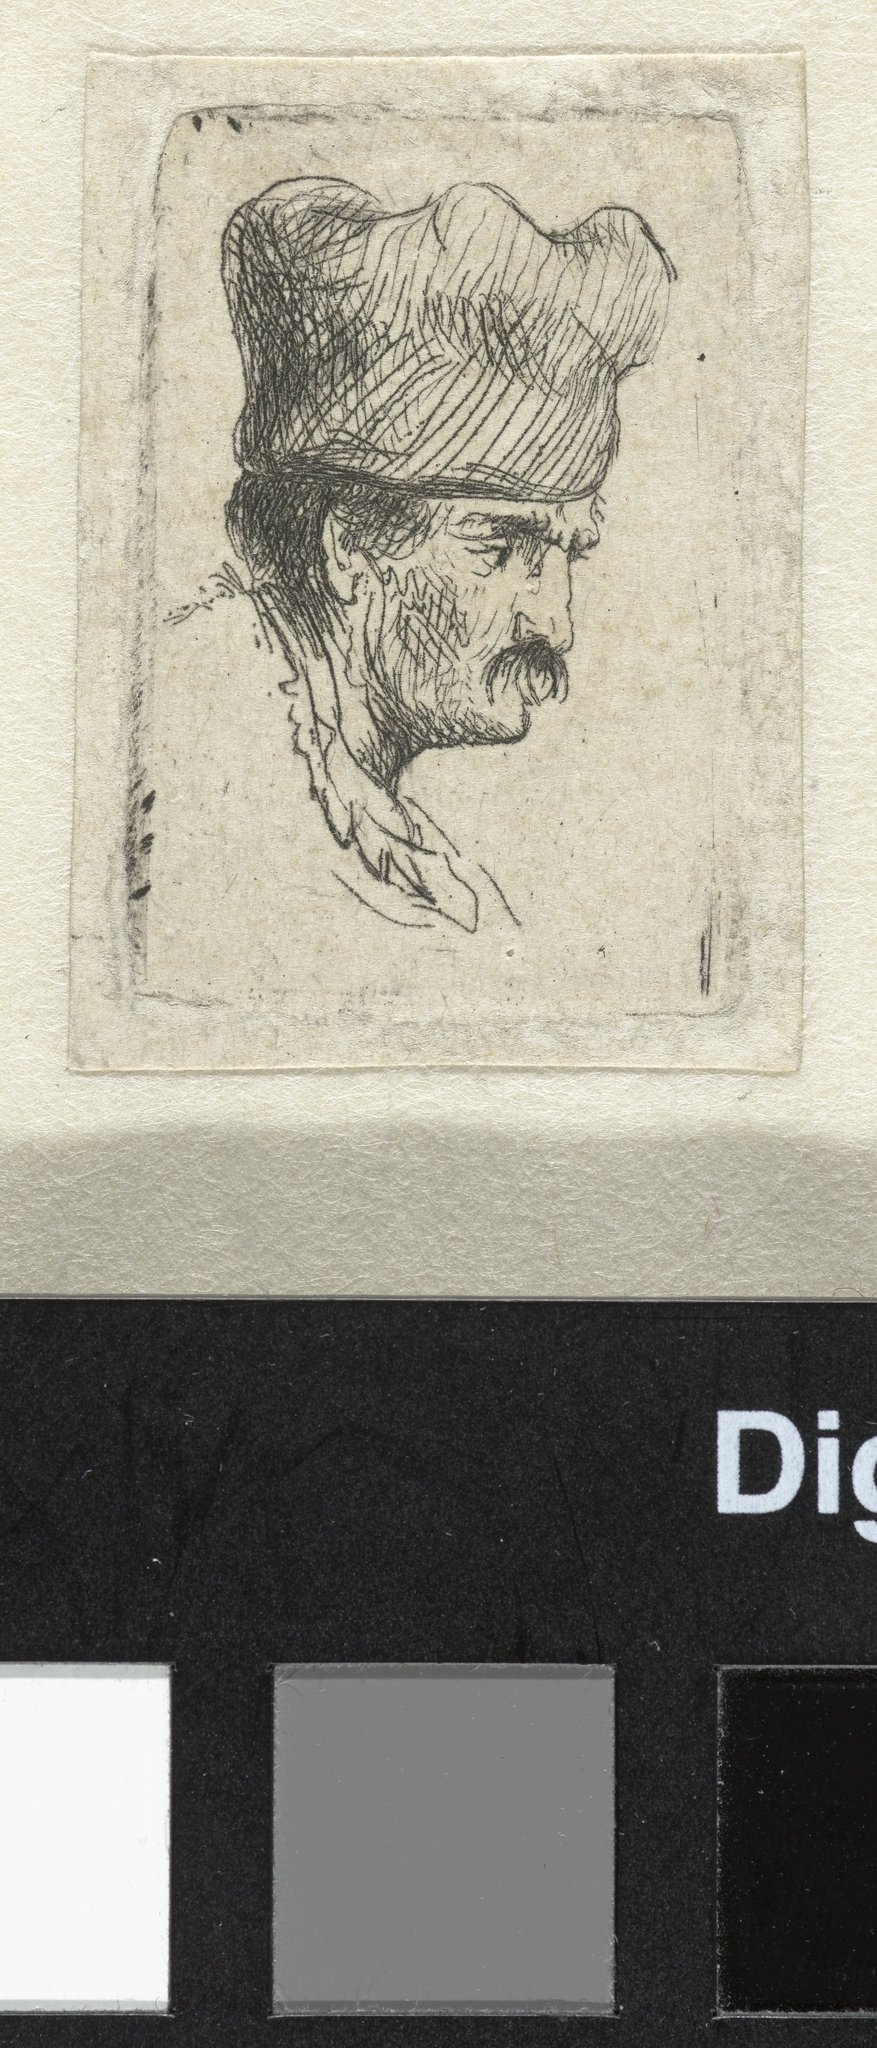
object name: print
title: Man in a square cap, in profile right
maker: james hazard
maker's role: print maker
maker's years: 1748-1787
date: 1758-1787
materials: paper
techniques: etching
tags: head-gear: cap (+ men's clothes)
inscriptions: collector's mark: Lugt 2228